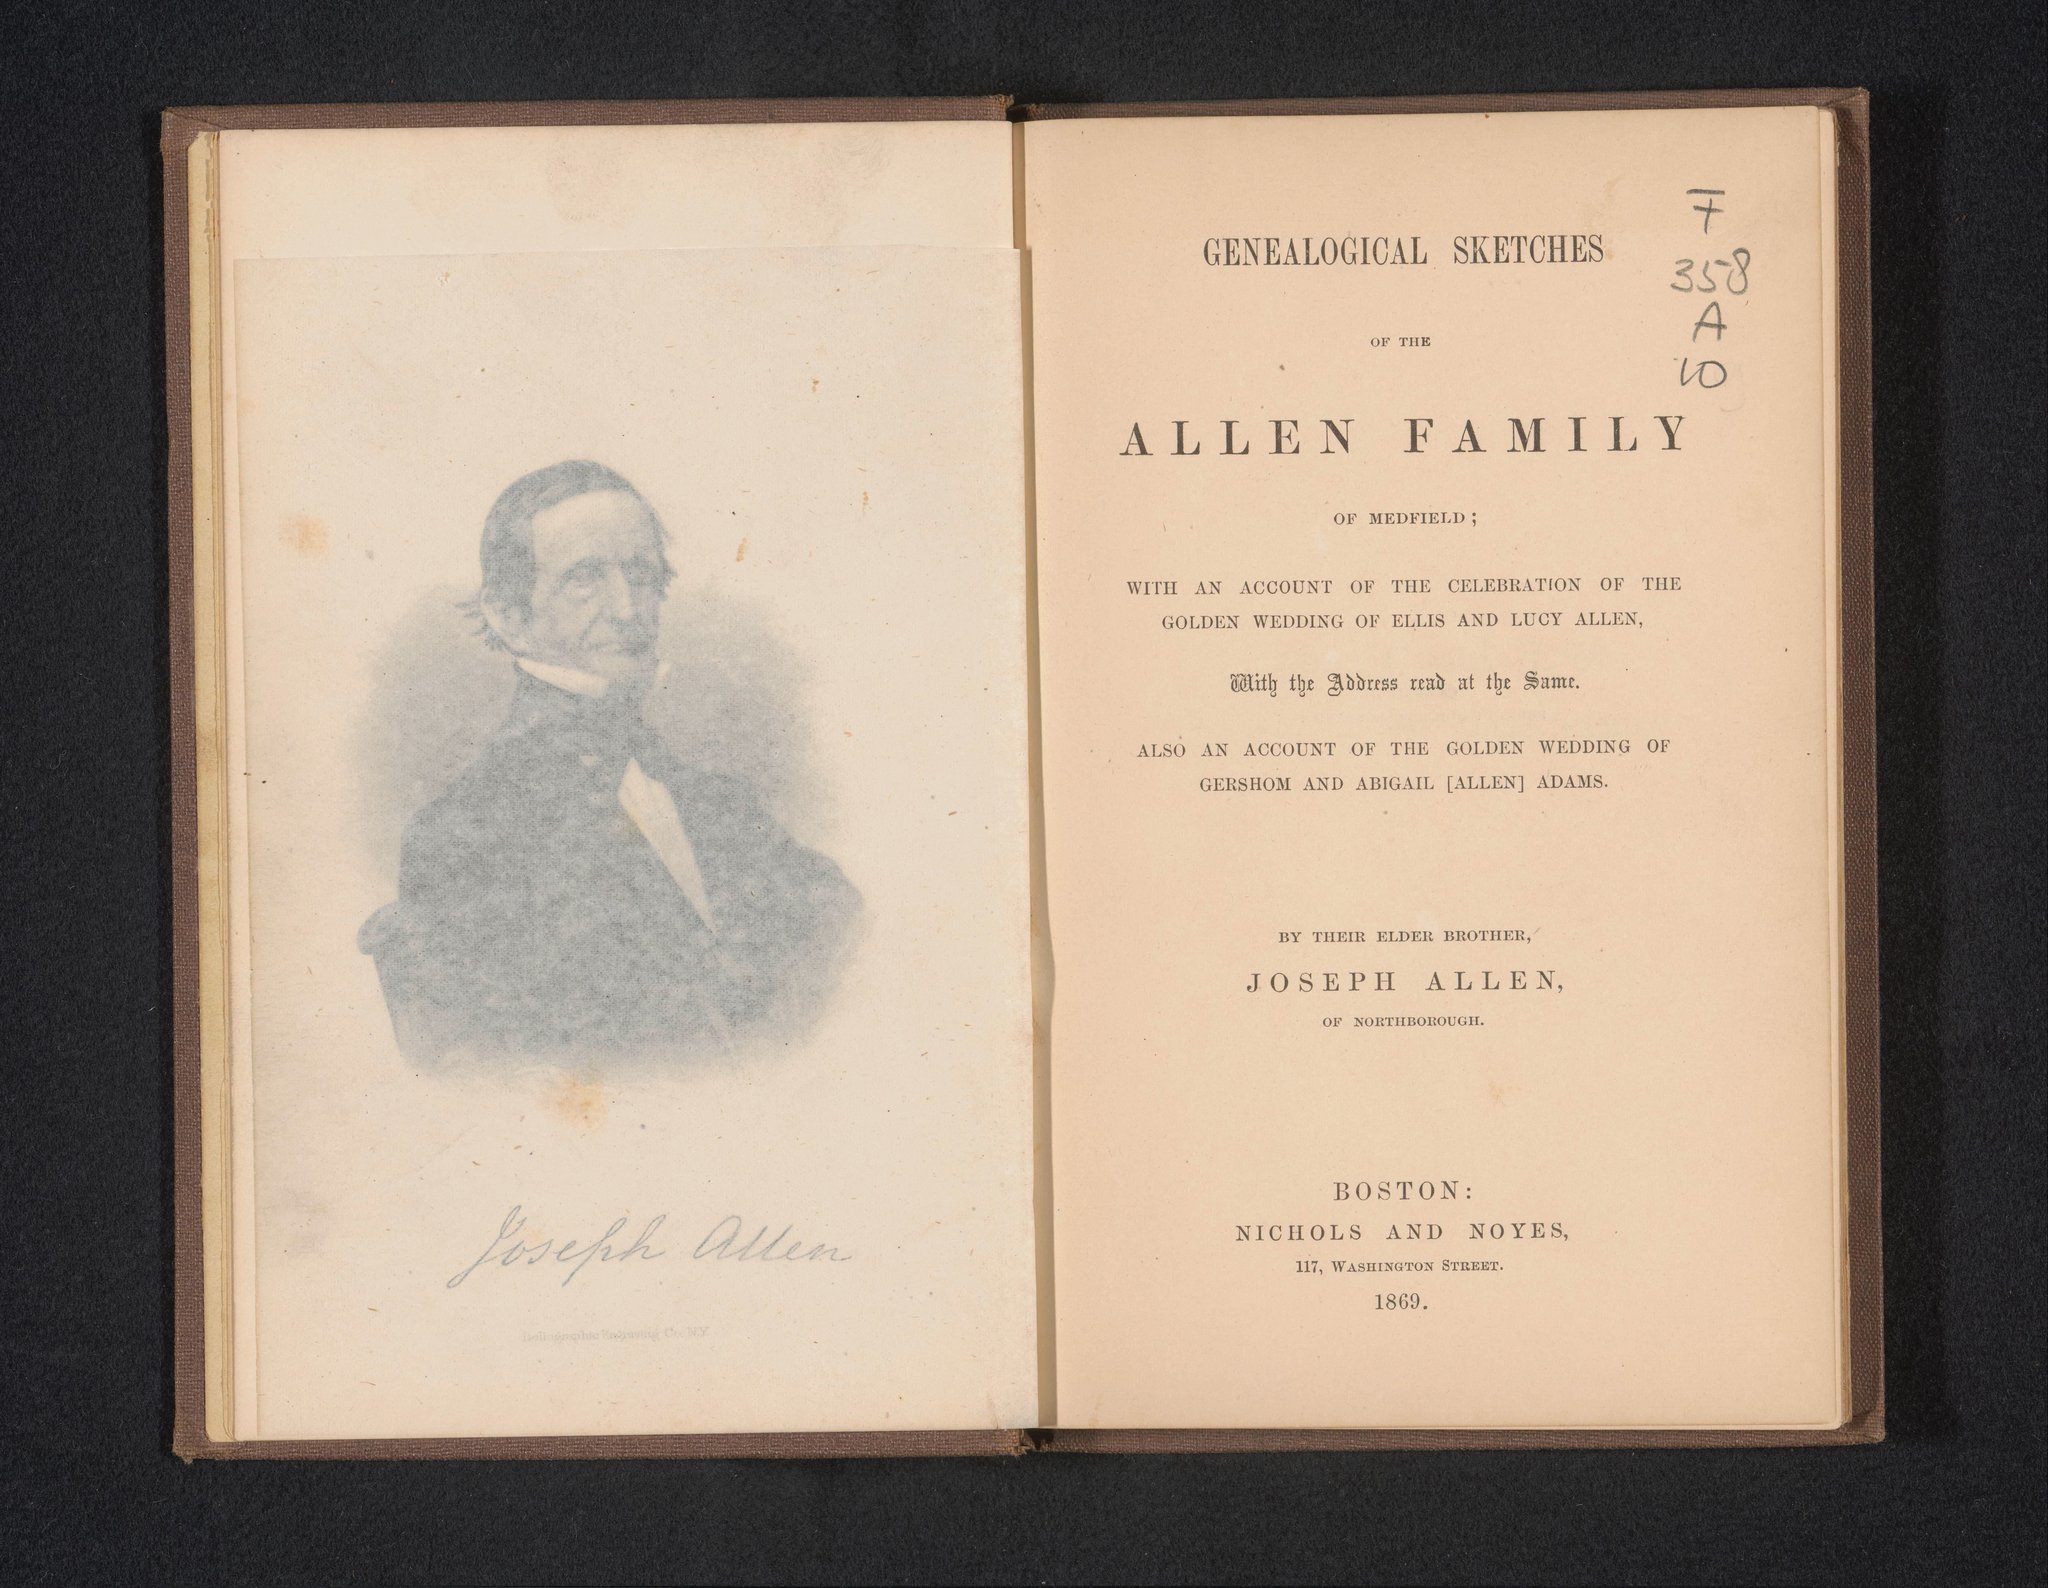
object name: book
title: Genealogical sketches of the Allan family of Medfield ; with an account of the celebration of the golden wedding of Ellis and Lucy Allen, ... [etc.]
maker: joseph allen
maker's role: clergyman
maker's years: 1820-1898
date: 1869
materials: linen, paper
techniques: photograph, printing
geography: boston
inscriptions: date: ‘Sept 2000’